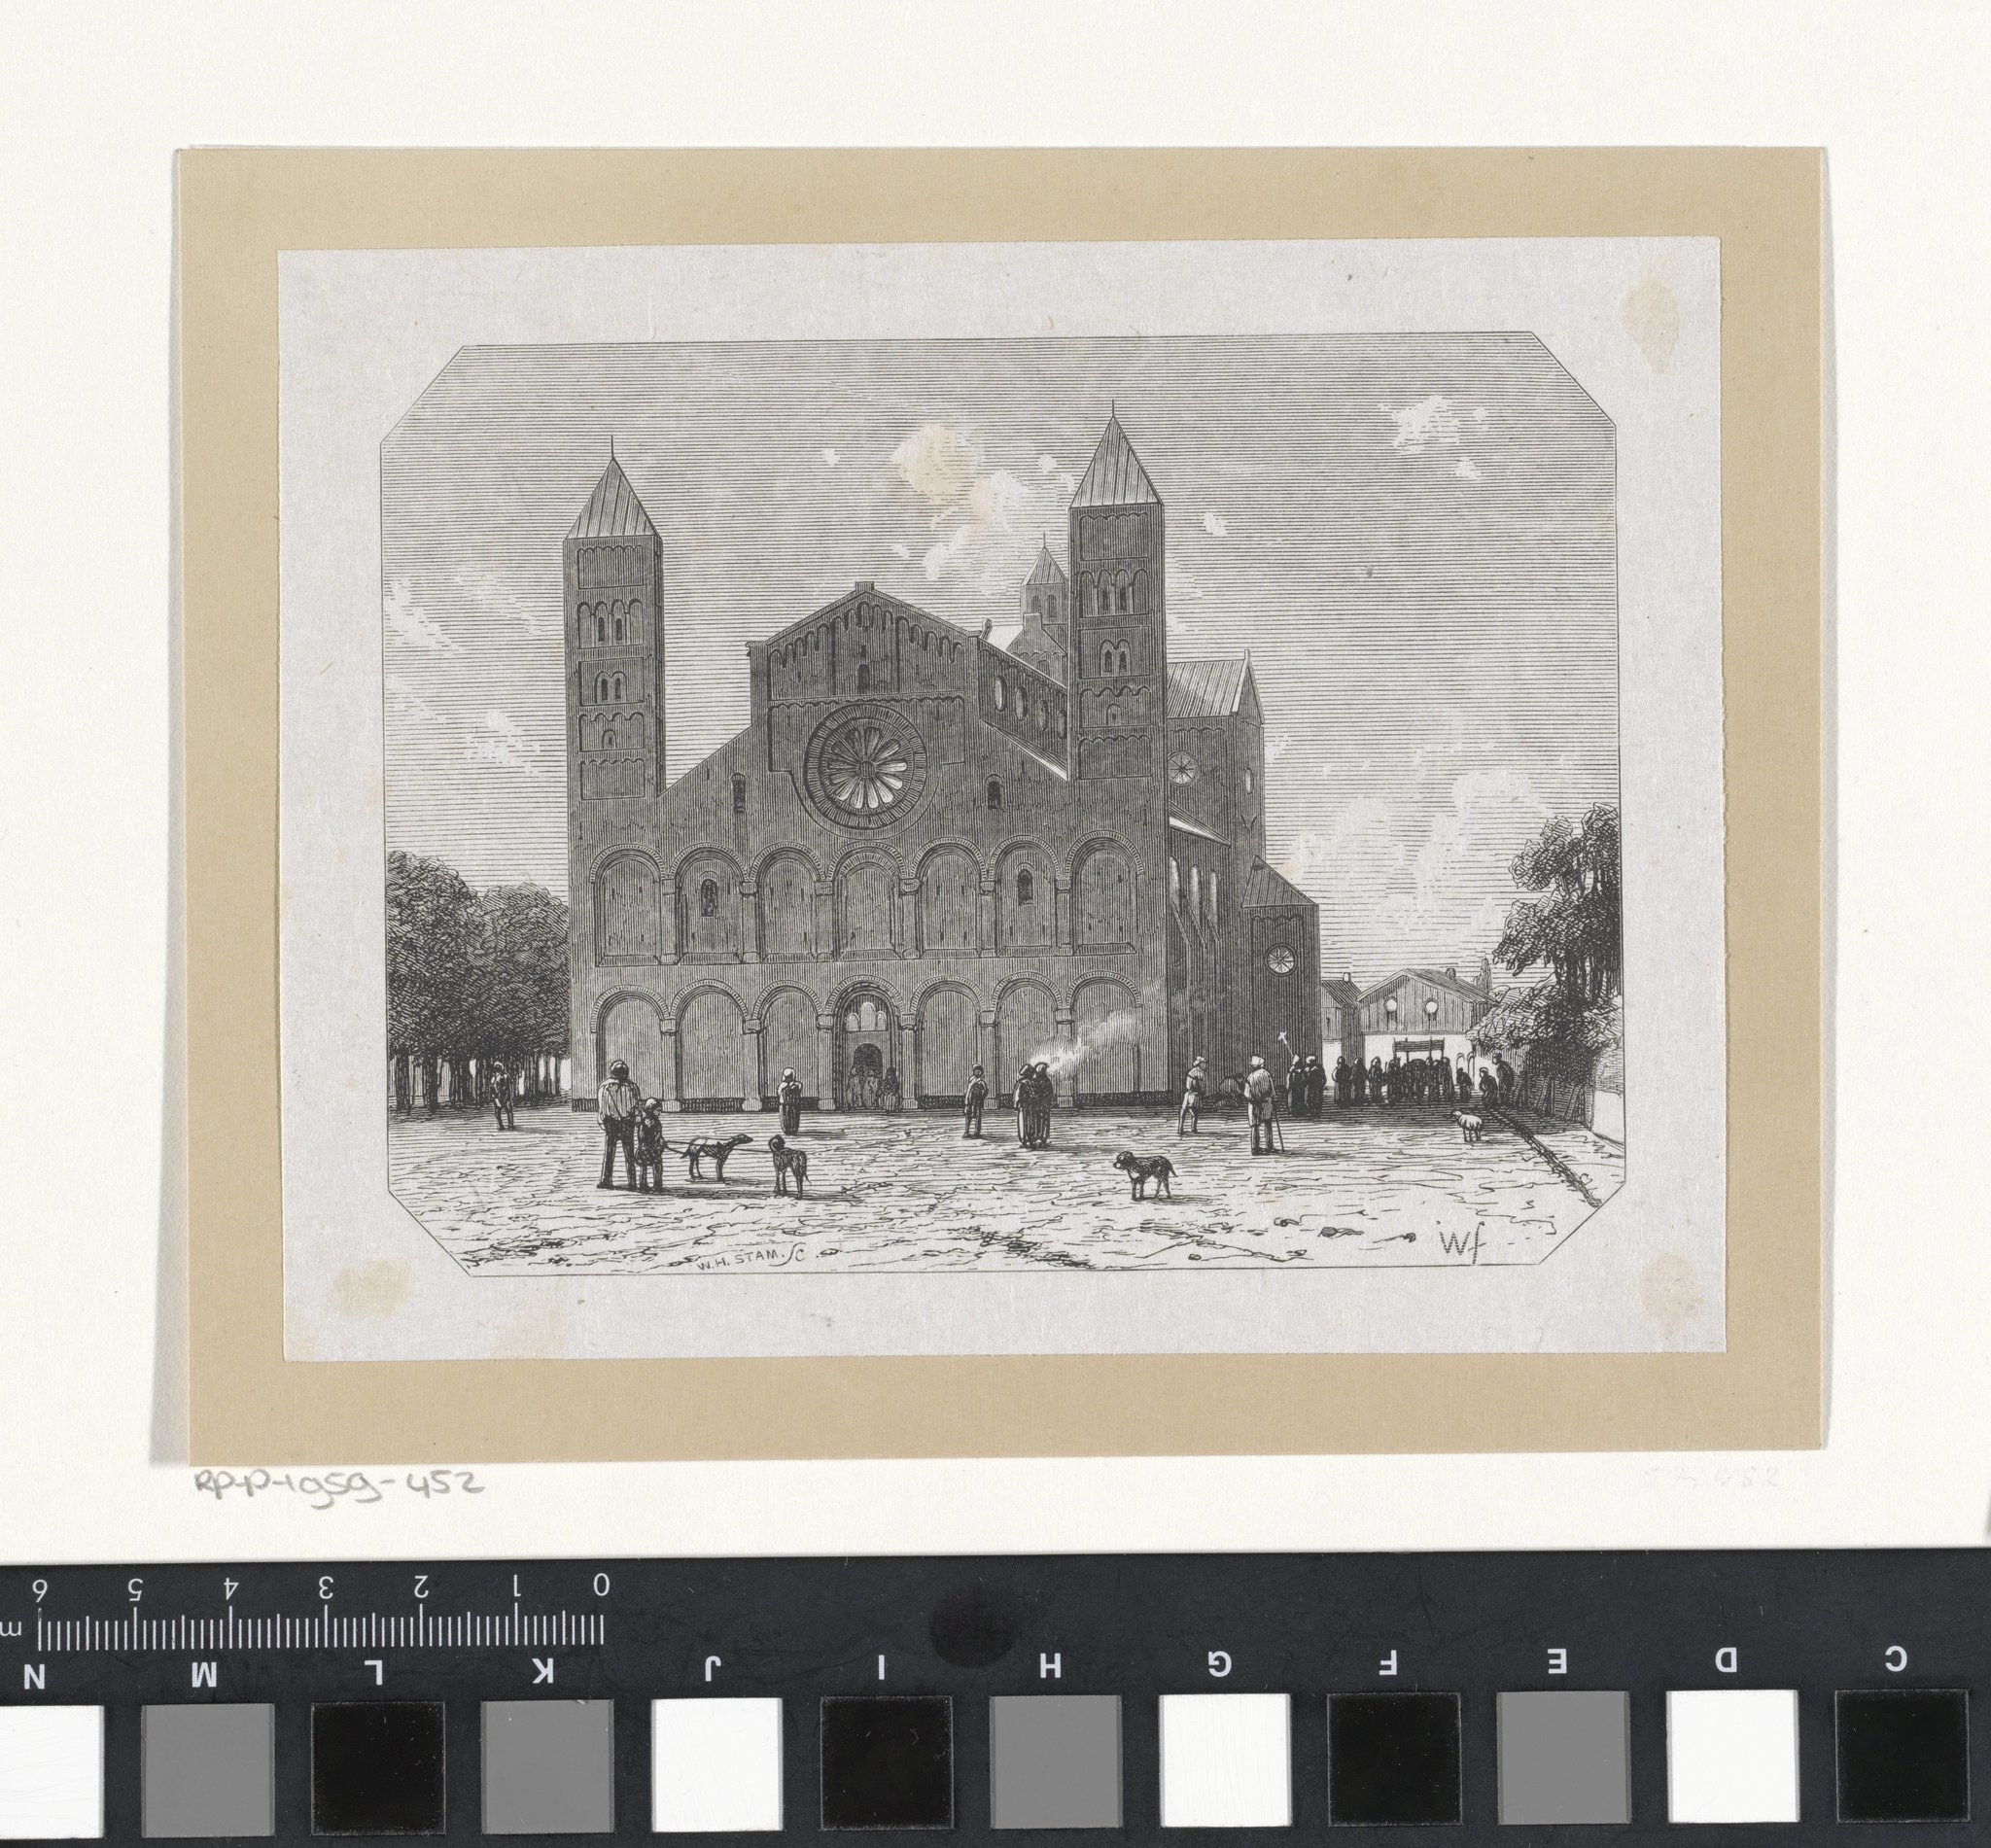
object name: print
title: Ridderzaal te Den Haag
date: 1841-1874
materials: paper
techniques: engraving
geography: the hague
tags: ridderzaal